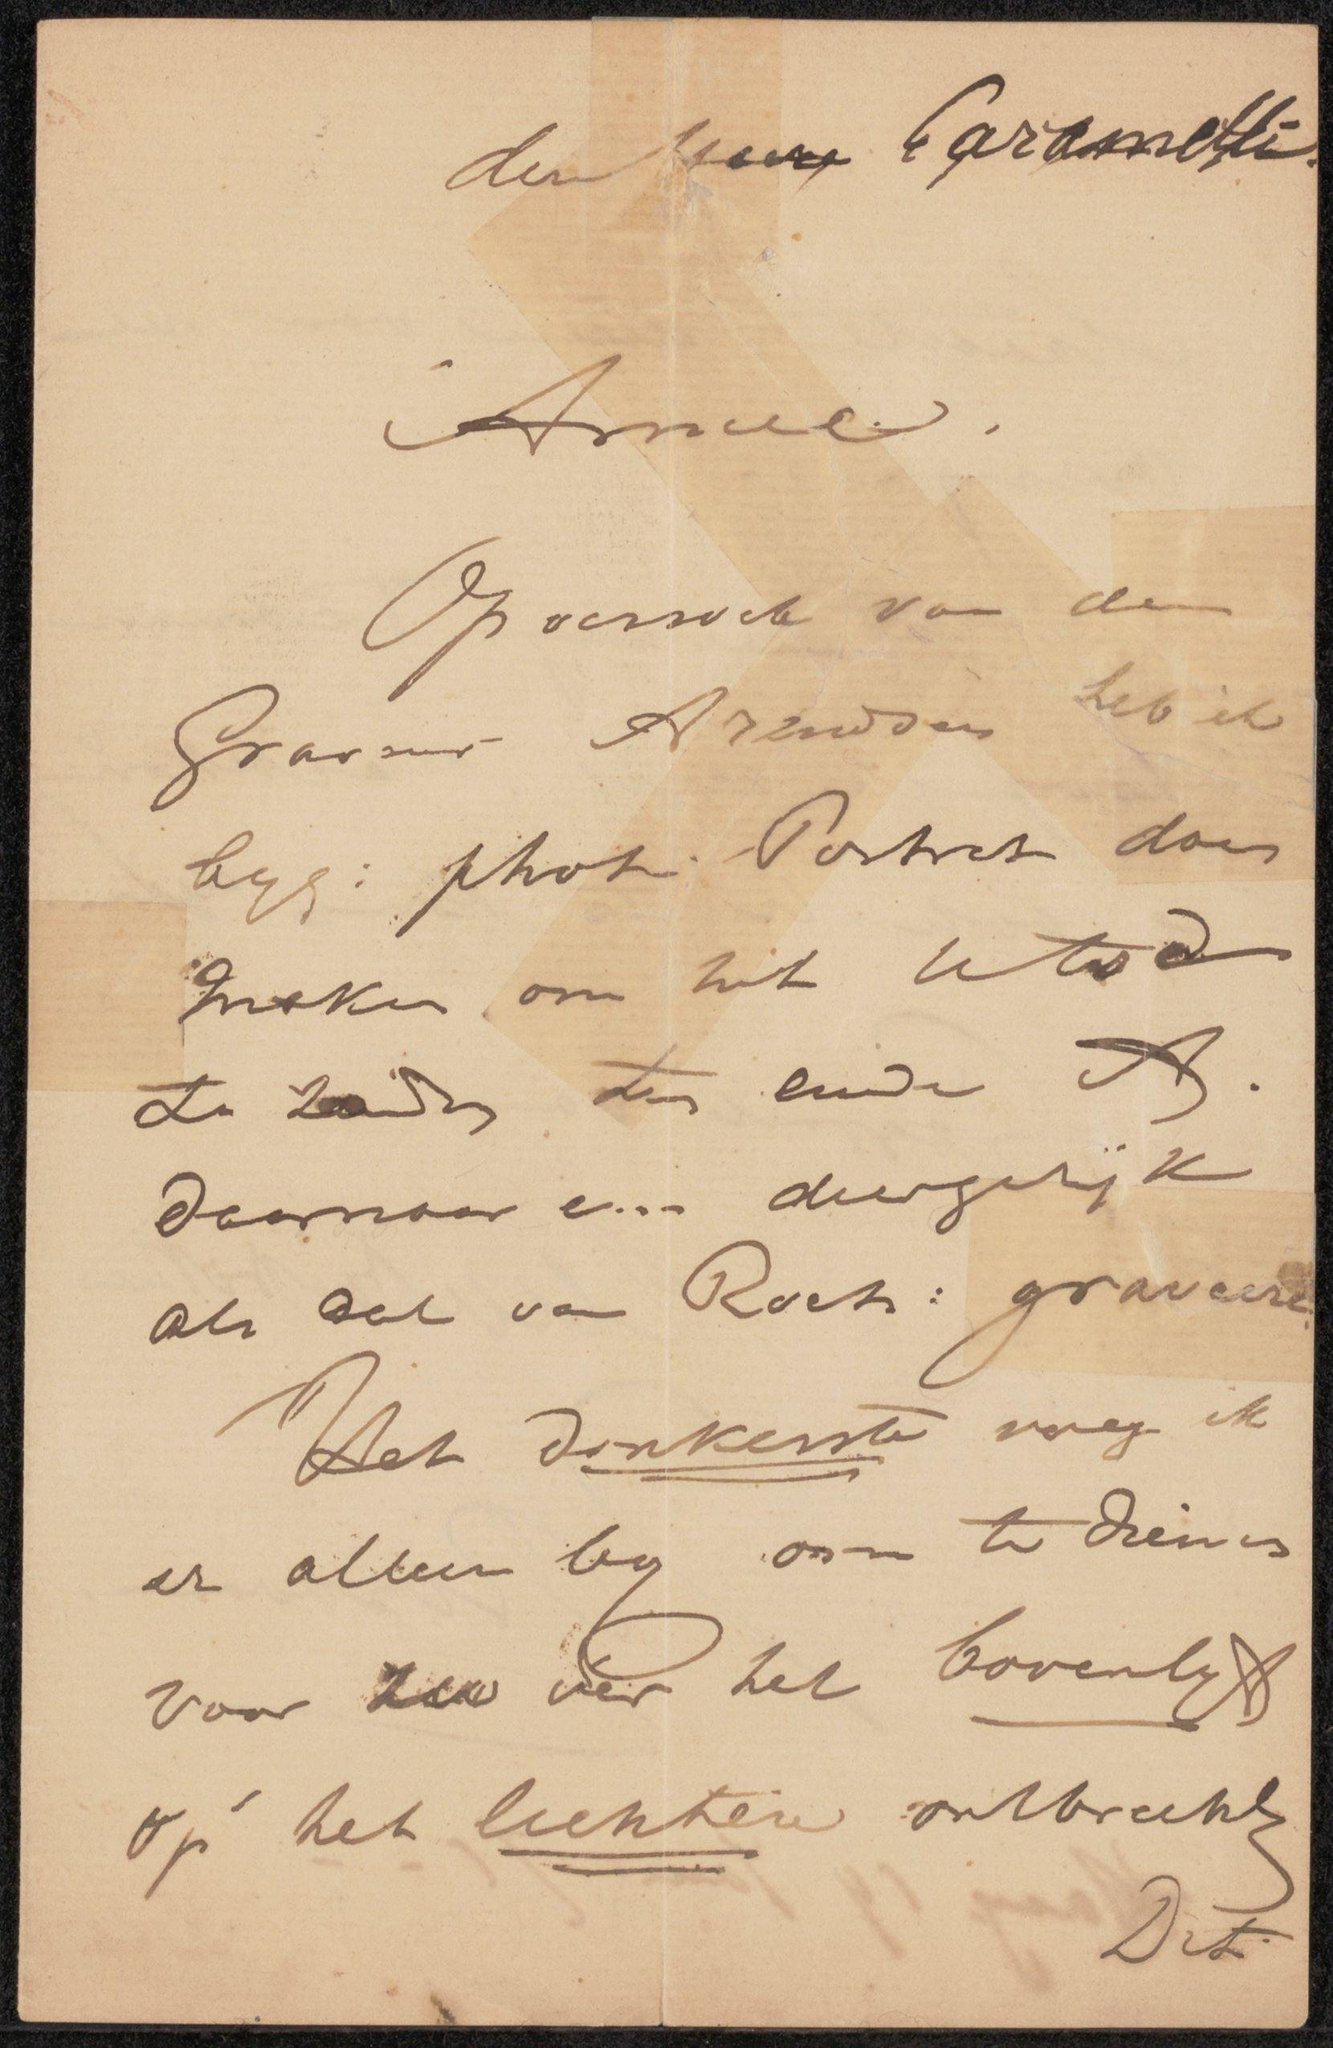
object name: letter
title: Brief aan Alberto Caramelli of Giovanni Caramelli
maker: johannes bosboom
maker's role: draughtsman, painter, print maker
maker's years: 1817-1891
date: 1871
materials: ink, paper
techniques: pen, writing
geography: the hague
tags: utrecht, publisher, alberto caramelli, amsterdam, print maker, draughtsman, petrus johannes arendzen, jan caramelli, photography, cinematography, the graphic arts, historical persons (portraits and scenes from the life)